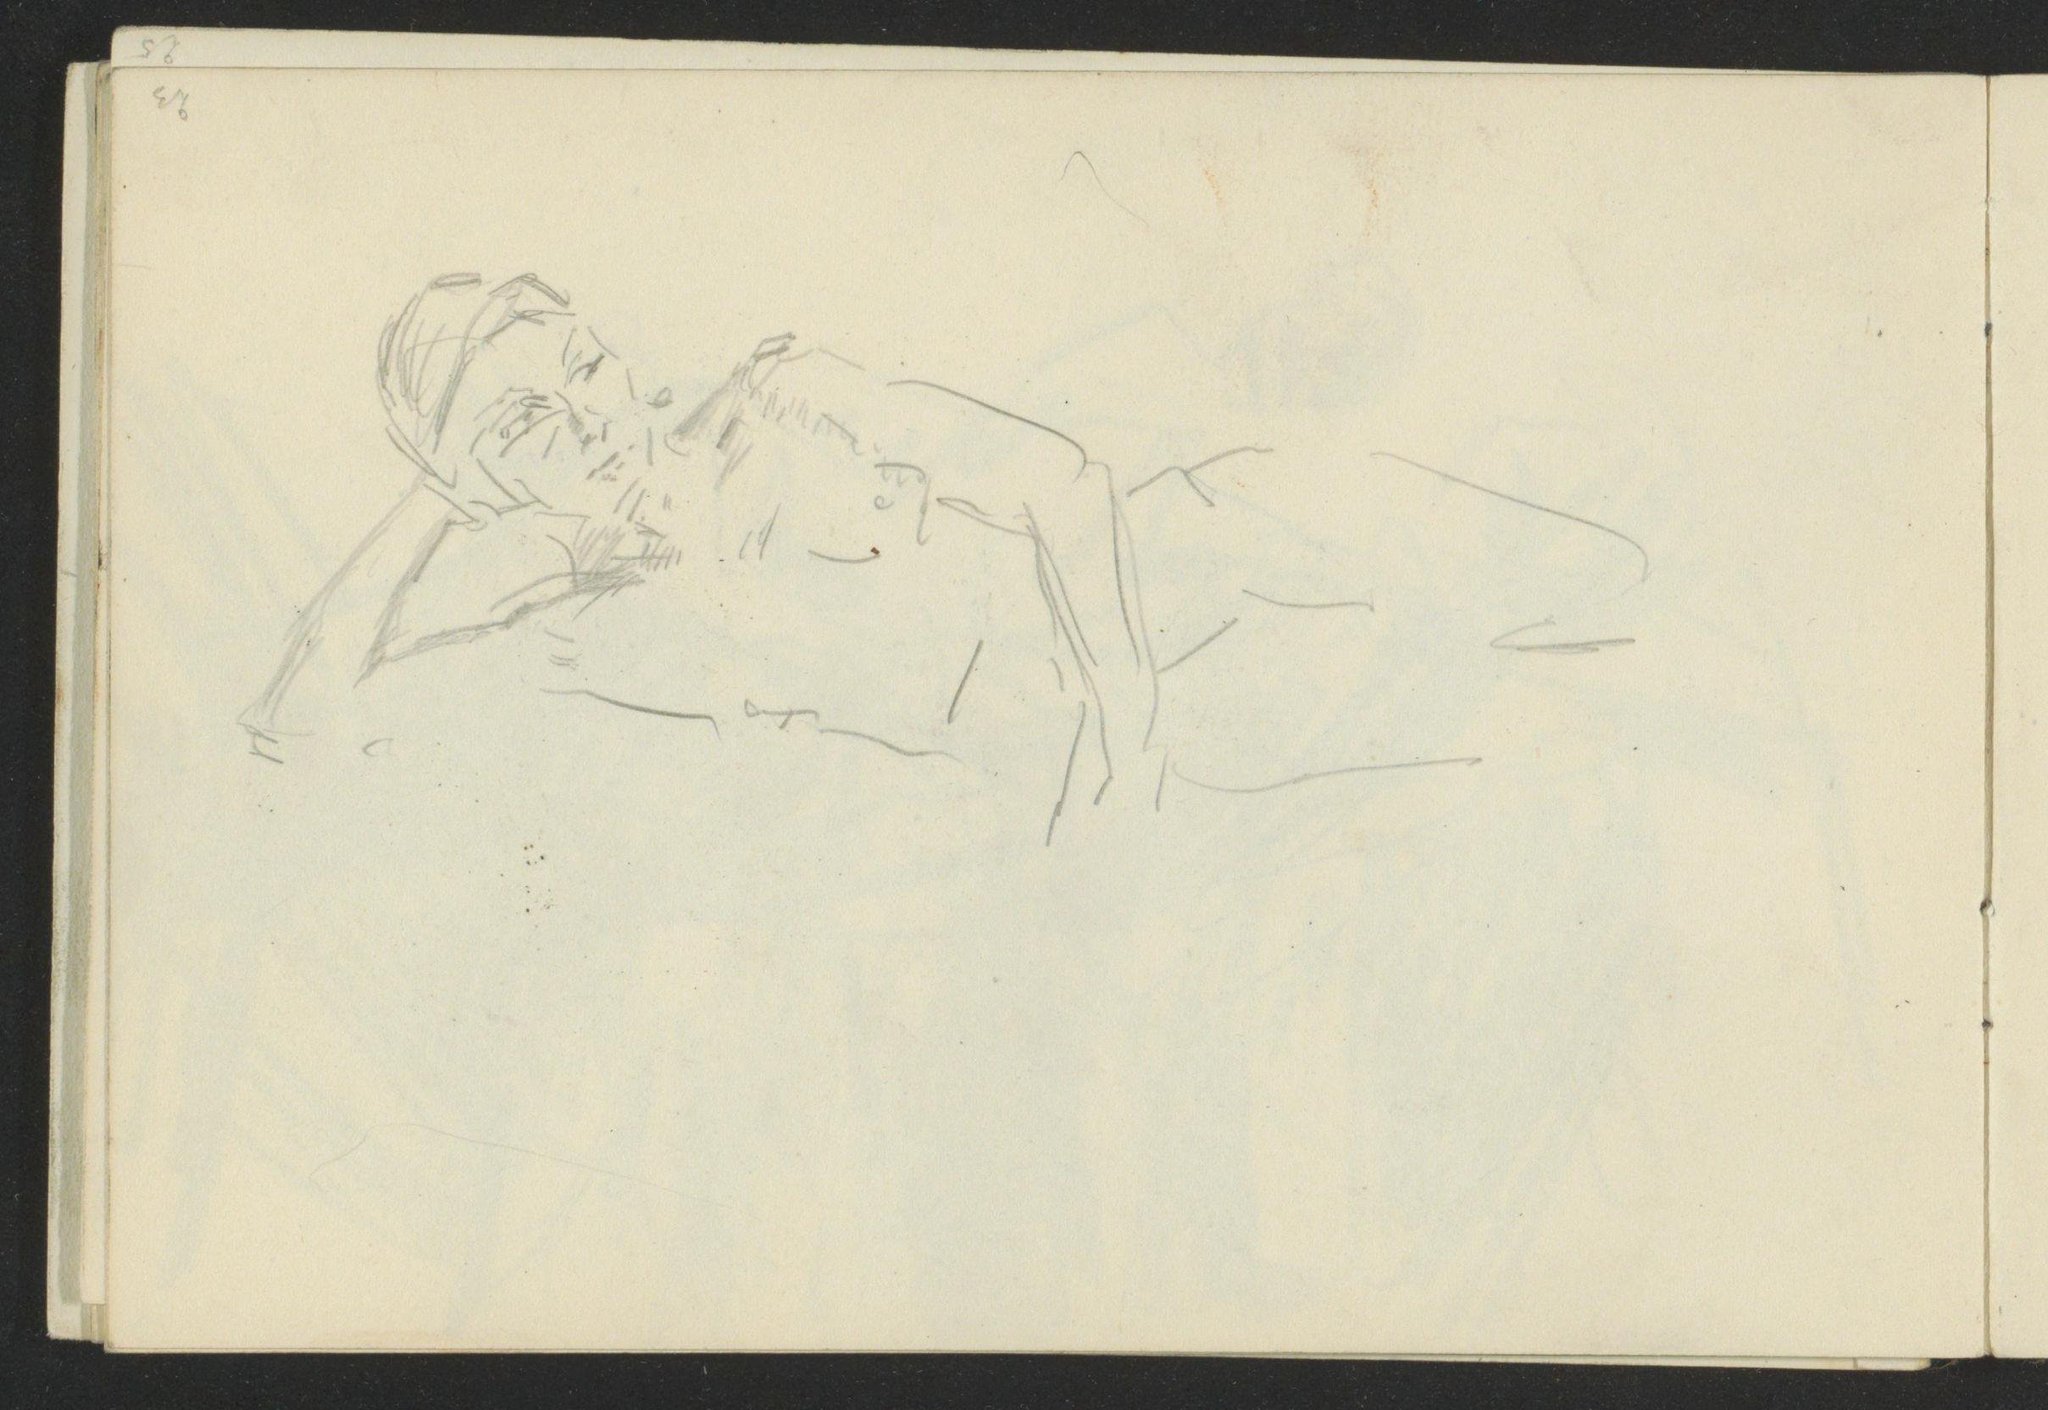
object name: sketchbook leaf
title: Reclining Female Nude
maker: isaac israels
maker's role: draughtsman, painter, print maker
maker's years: 1865-1934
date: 1875-1934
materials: paper, pencil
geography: the hague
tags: lying on one side, with uplifted upper part of the body and leaning on the arm - aa - female human figure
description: Ze ligt op haar zij en steunt op een arm. Blad 18 verso uit schetsboek LXI met 20 bladen.